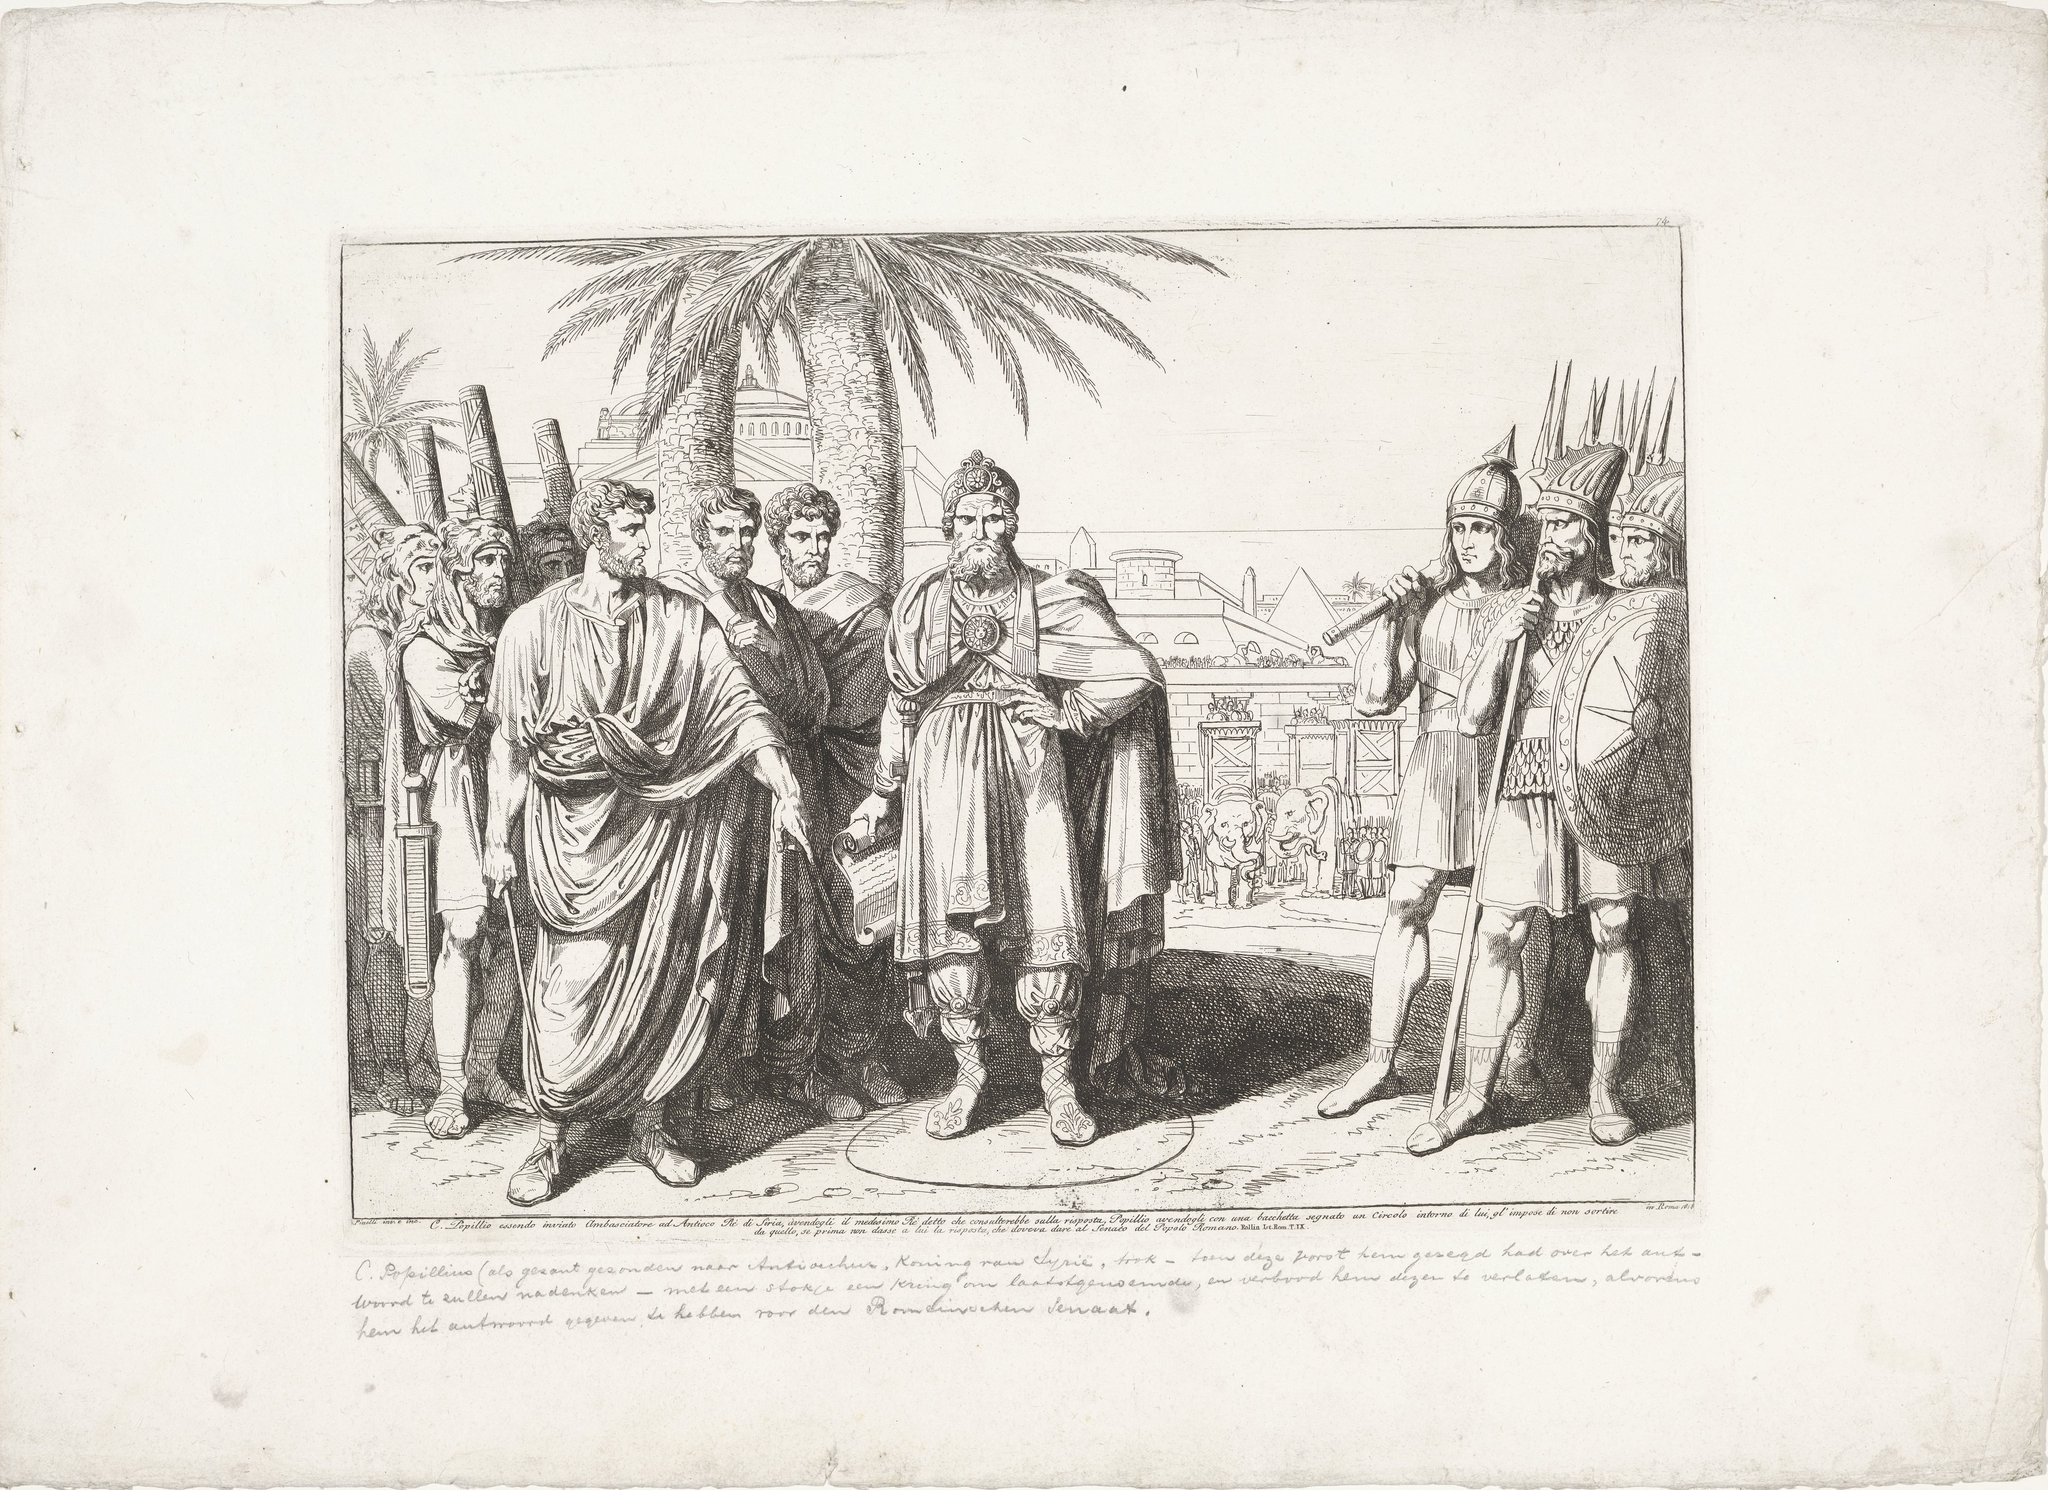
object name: print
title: Gaius Popillius Laenas trekt cirkel om Antiochus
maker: bartolomeo pinelli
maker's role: draughtsman, print maker, sculptor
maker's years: 1781-1835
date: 1818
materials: paper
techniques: etching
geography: rome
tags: history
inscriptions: collector's mark: Lugt 2228, inscription: ‘C. Popillius (als gezant gezonden naar Antiochus, Koning van Syrië, trok - toen deze vorst hem gezegd had over het antwoord te zullen nadenken - met een stokje een kring om laatstgenoemde, en verbood hem dezen te verlaten, alvorens / hem het antwoord gegeven te hebben voor den Romeinschen Senaat.’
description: Gaius Popillius Laenas trekt een cirkel om Antiochus en verbiedt hem de cirkel te verlaten voordat hij een vraag beantwoord heeft. Romeinse en Syrische soldaten kijken toe.